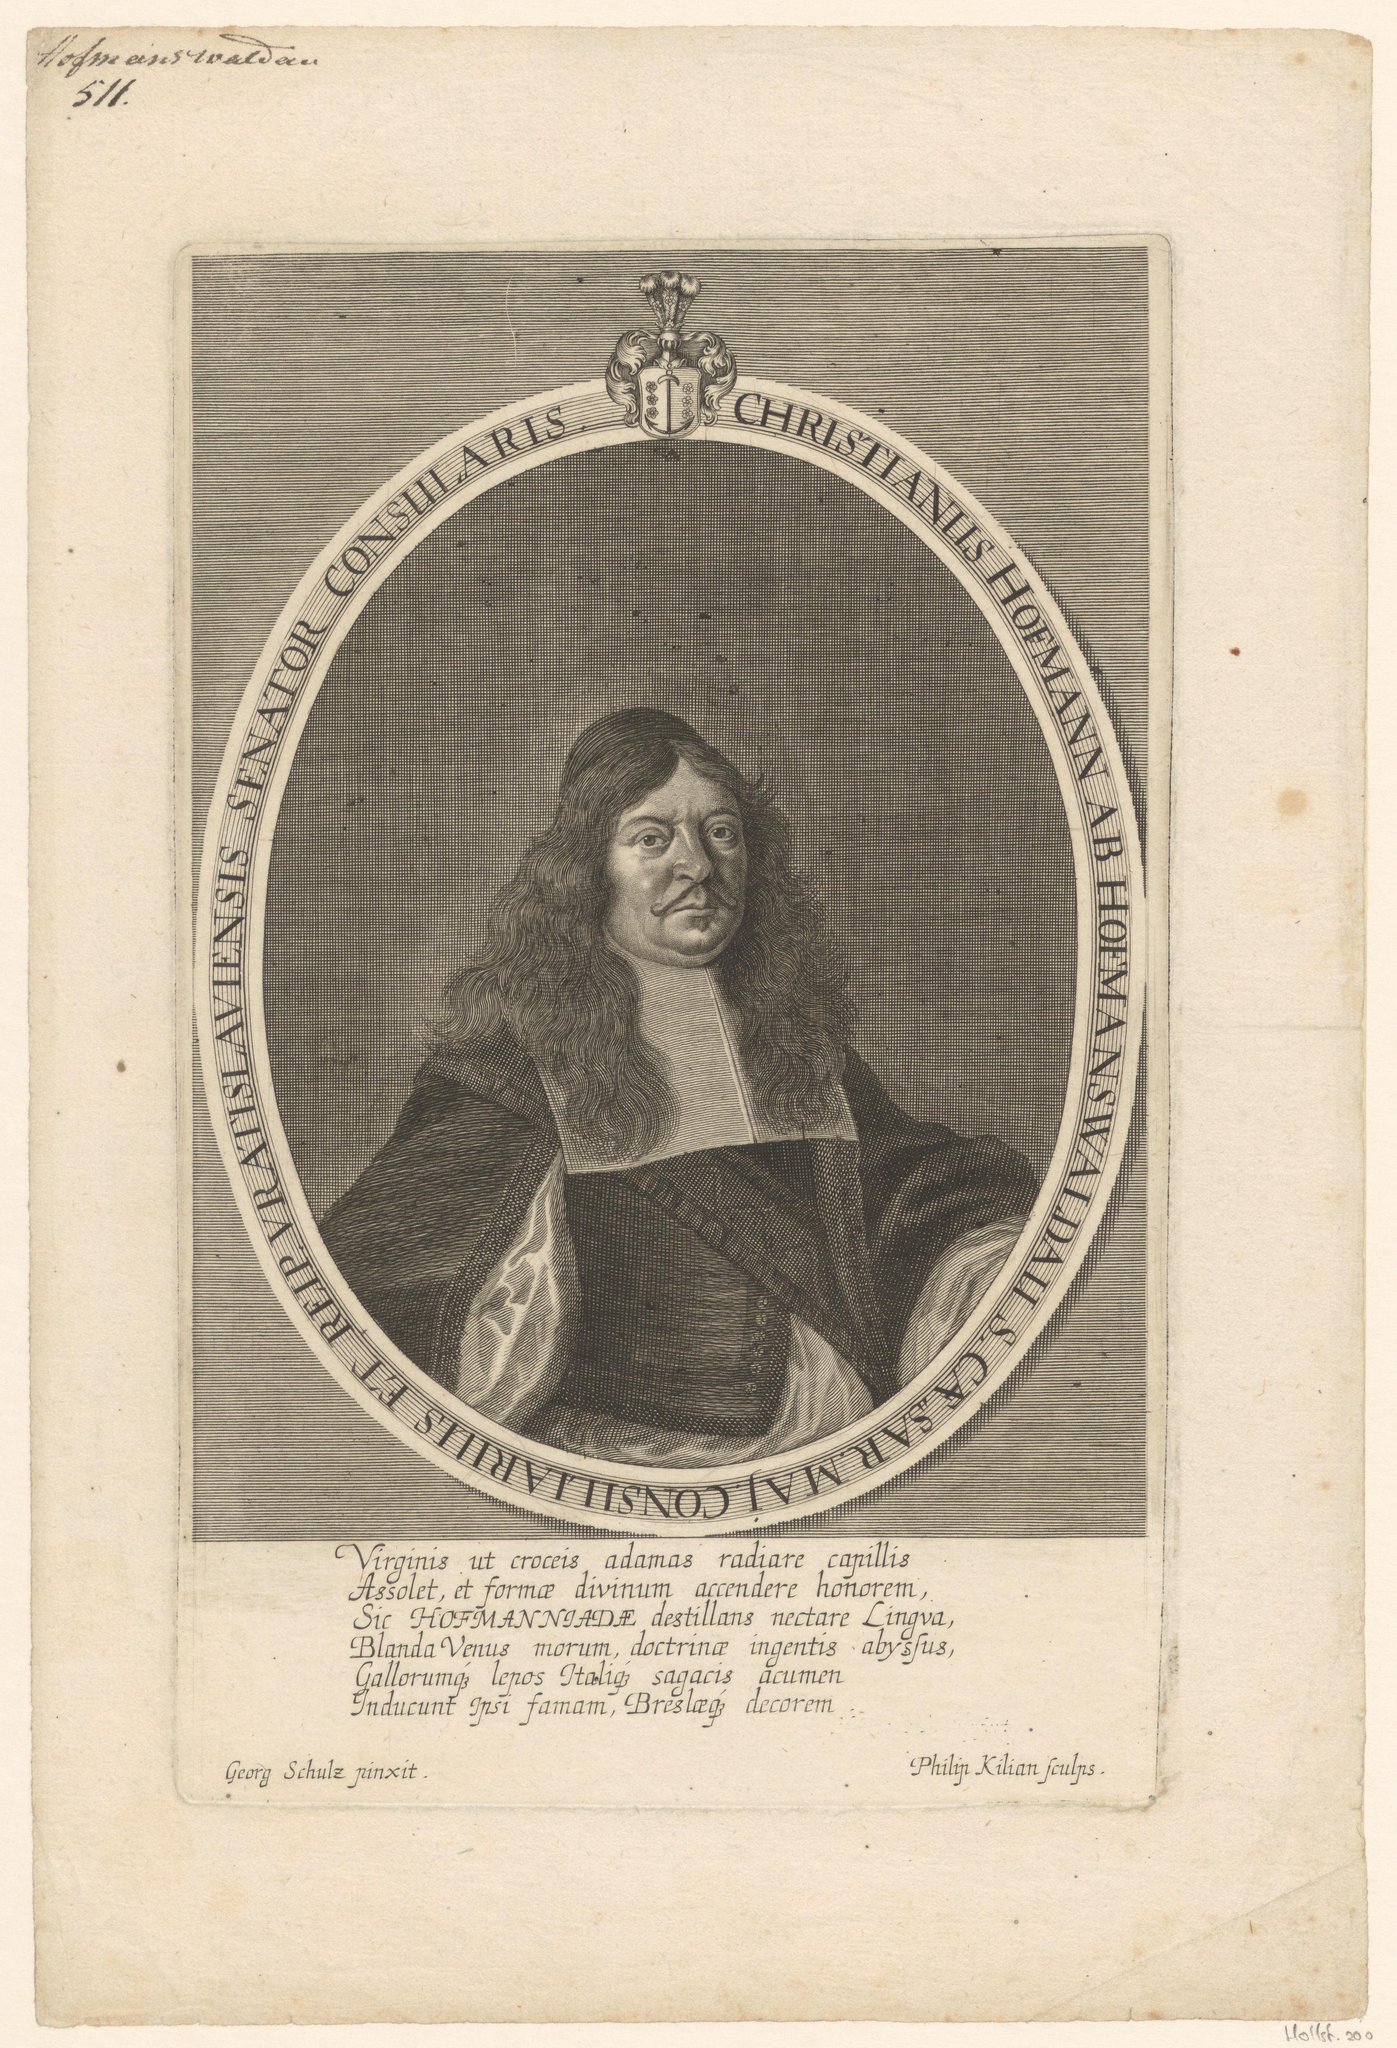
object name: print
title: Portret van Christian Hofmann von Hofmannswaldau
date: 1638-1693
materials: paper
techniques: engraving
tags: historical persons, counsellor, writer, poet, author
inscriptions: collector's mark: Lugt 2228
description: Tekst in het Latijn in de omlijsting en in de ondermarge.